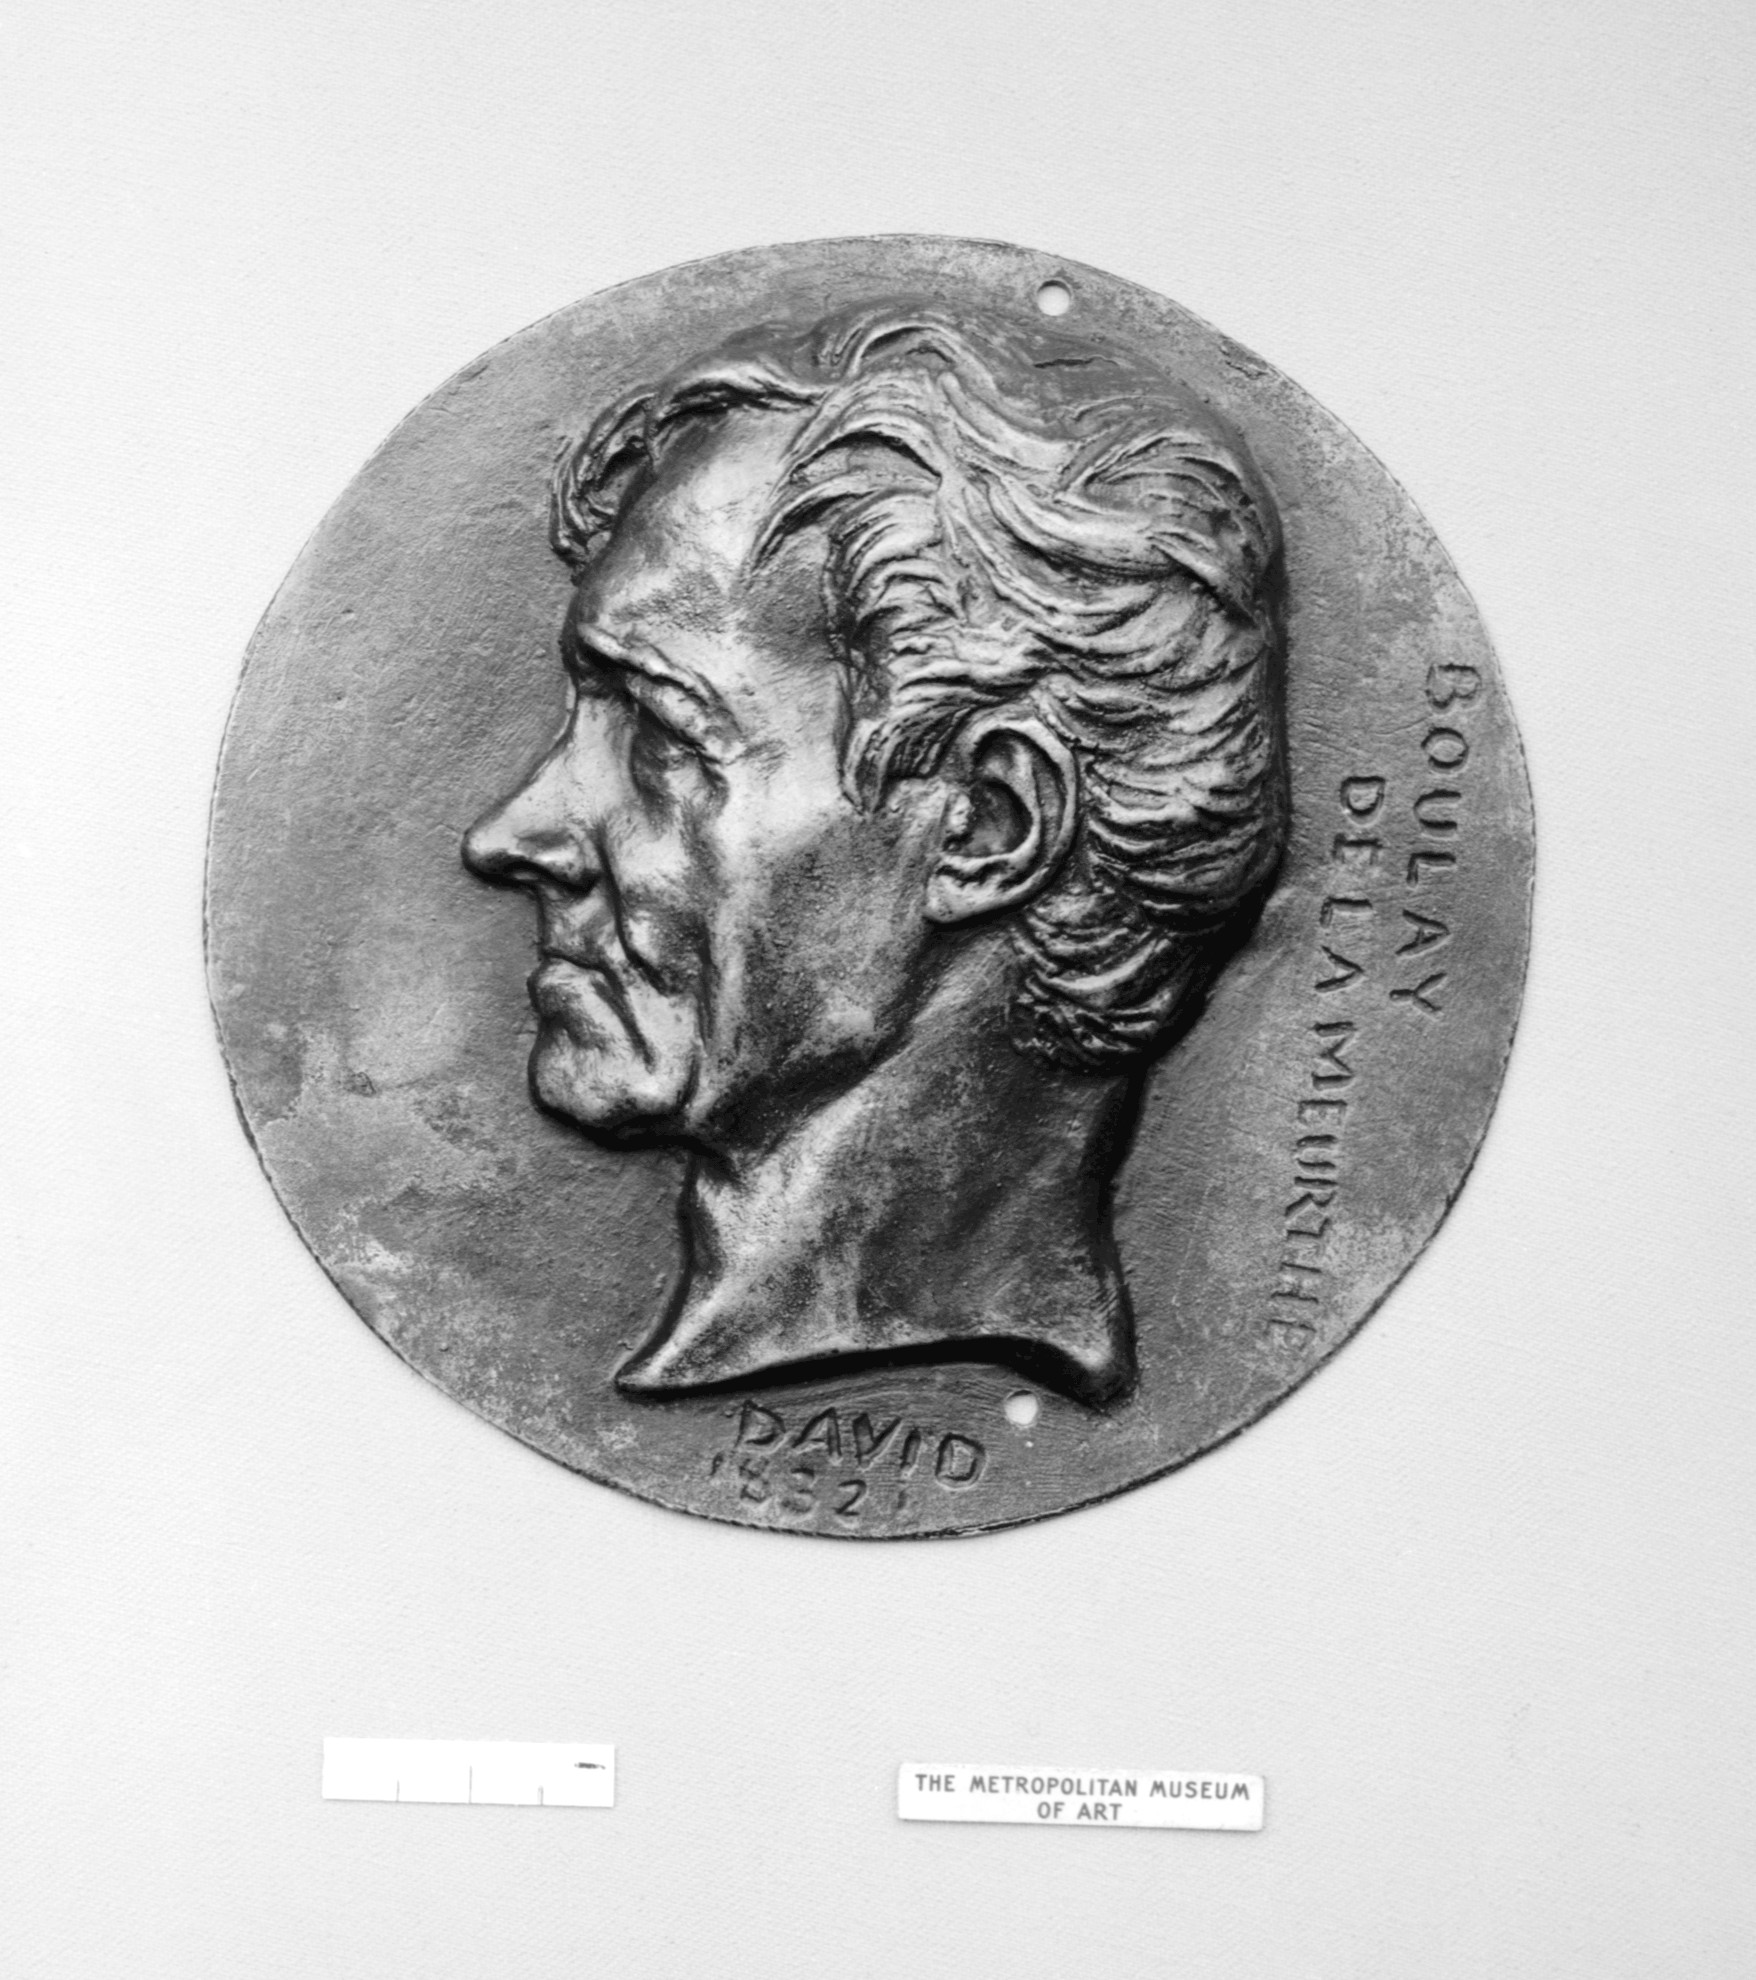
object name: medallion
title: Count (Antoine Jacques Claude Joseph) Boulay de la Meurthe , Polititian, Minister of State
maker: pierre jean david d'angers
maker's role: artist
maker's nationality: french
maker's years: 1788-1856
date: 1832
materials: bronze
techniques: casting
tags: men,profiles